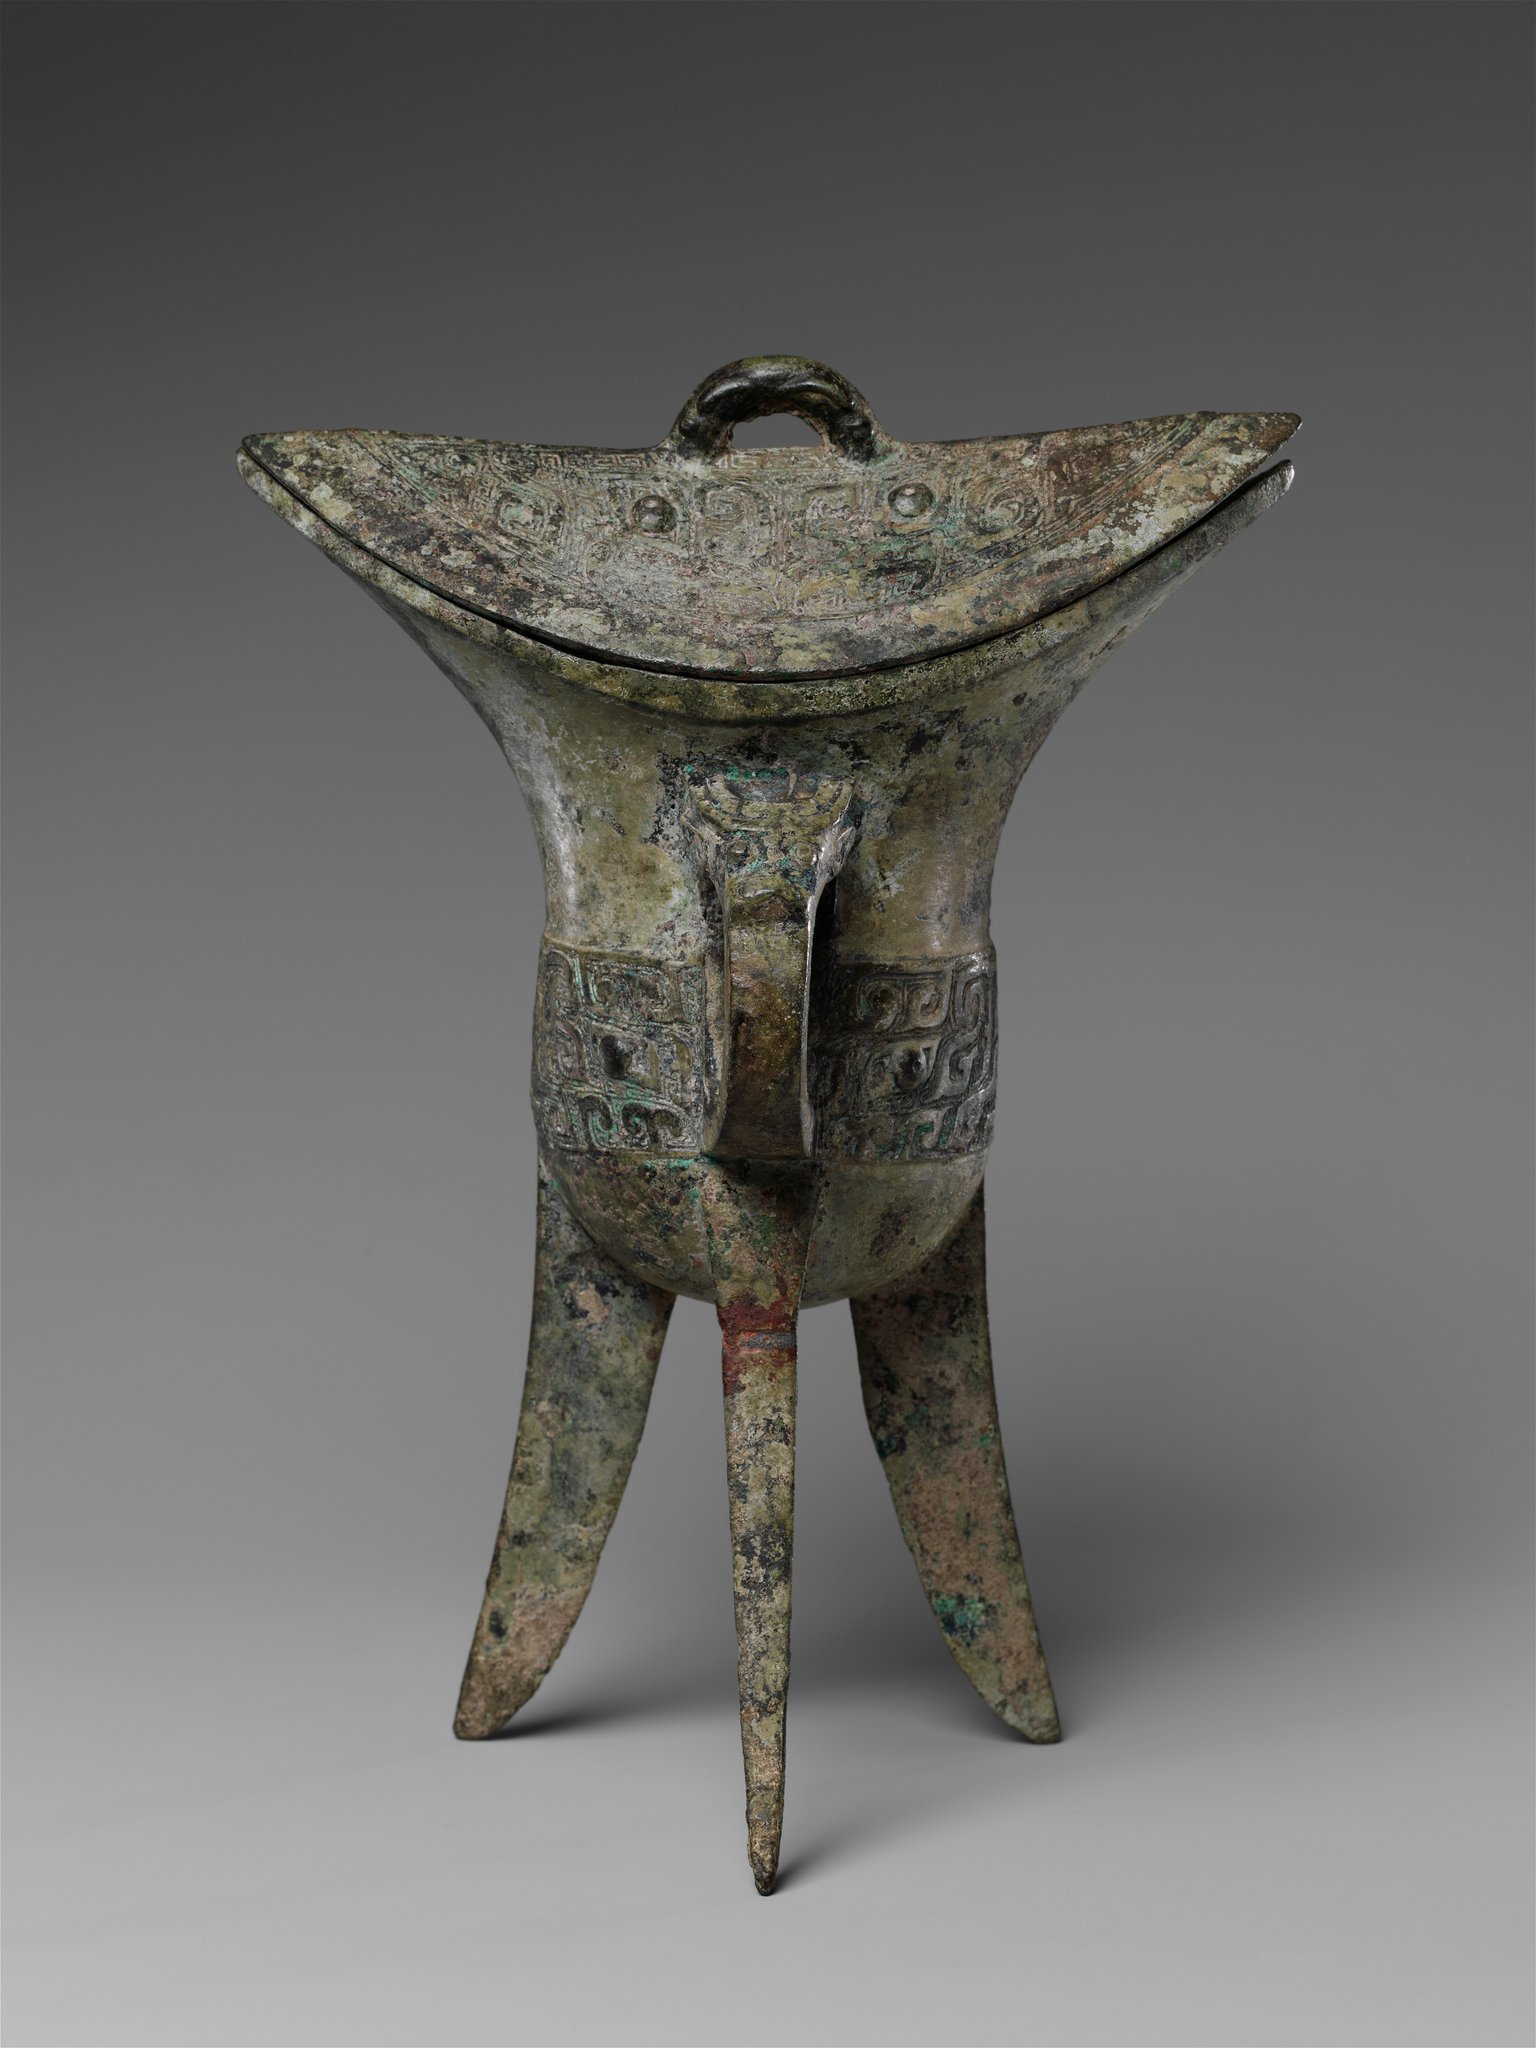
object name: wine warmer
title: Wine Warmer (Jiao)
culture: chinese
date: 1300-1001 BCE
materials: bronze